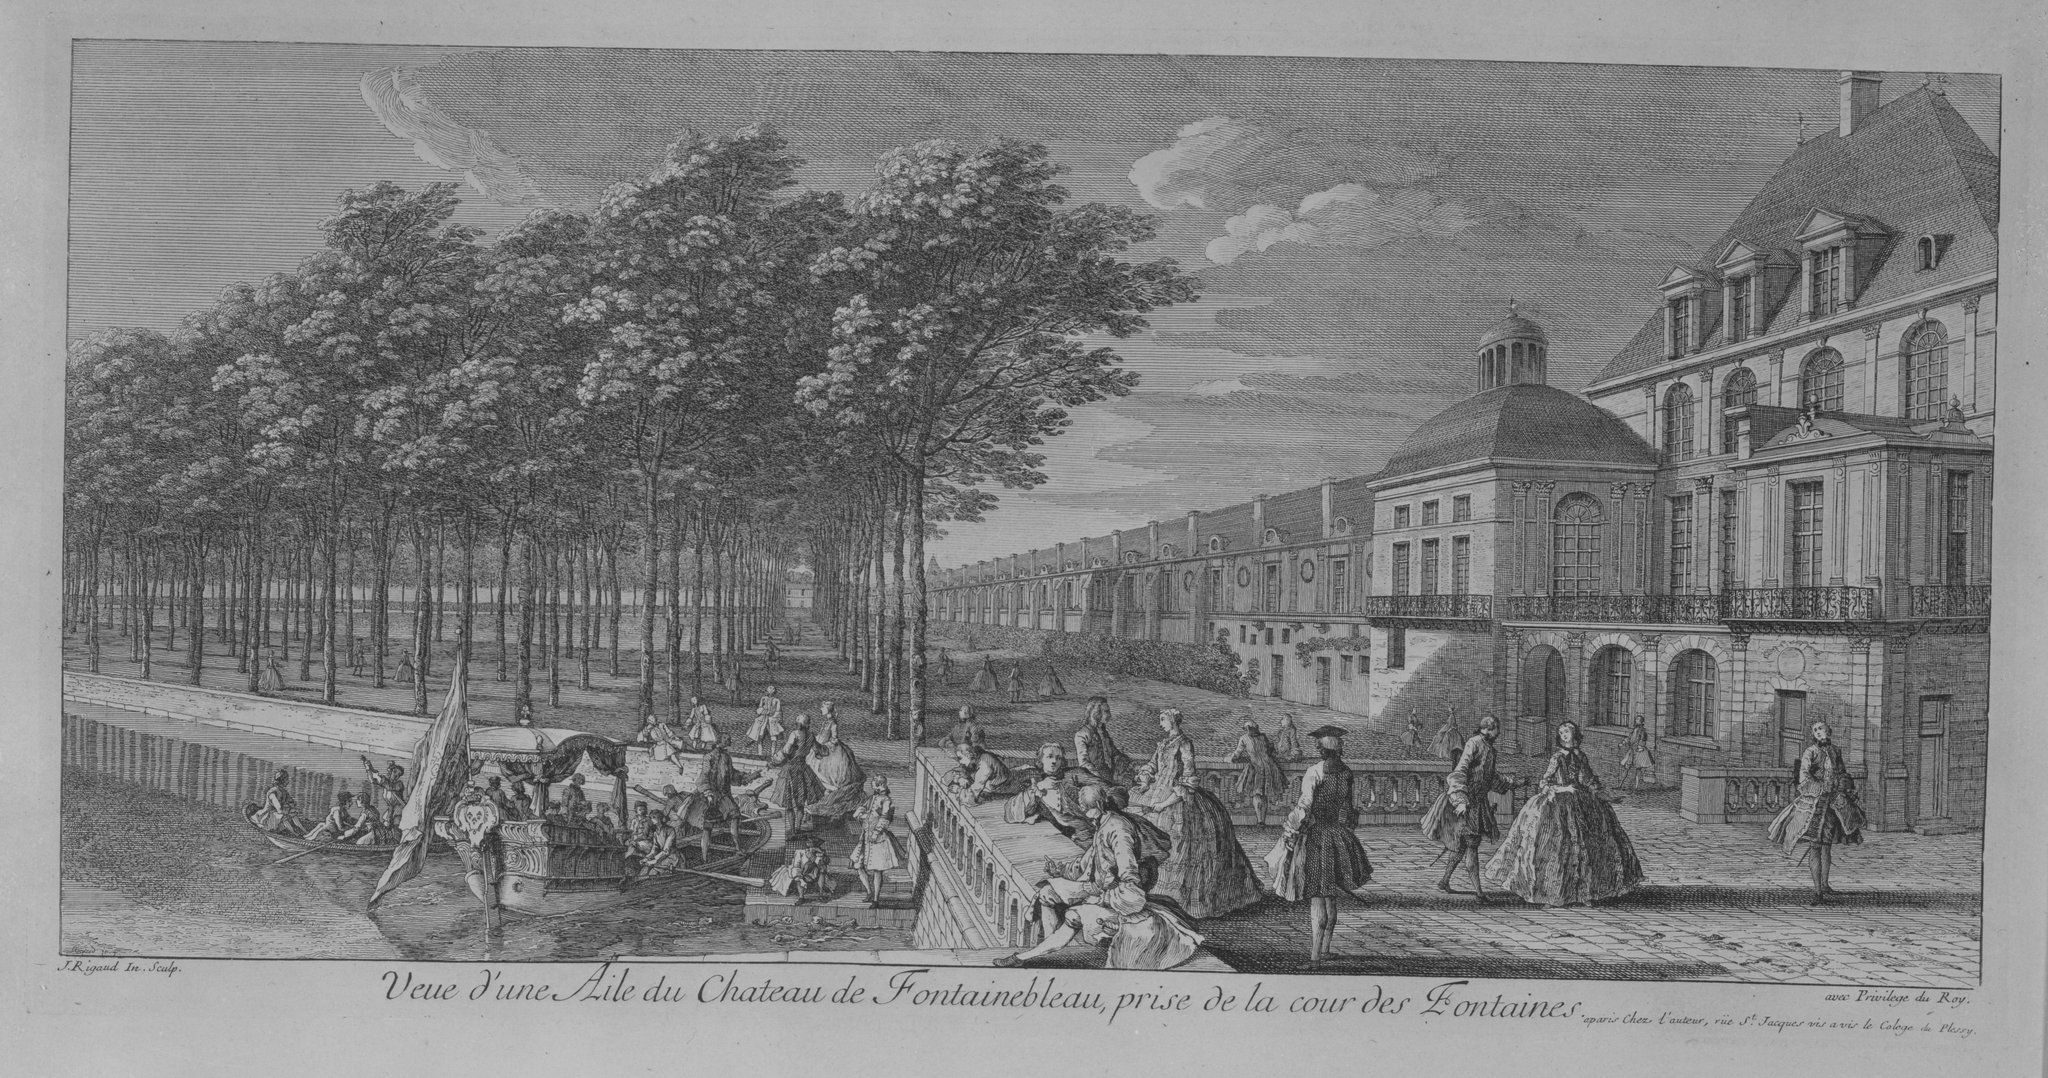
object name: book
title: Views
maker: jacques rigaud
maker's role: artist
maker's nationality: french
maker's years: 1681-1754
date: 1720-1754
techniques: etching